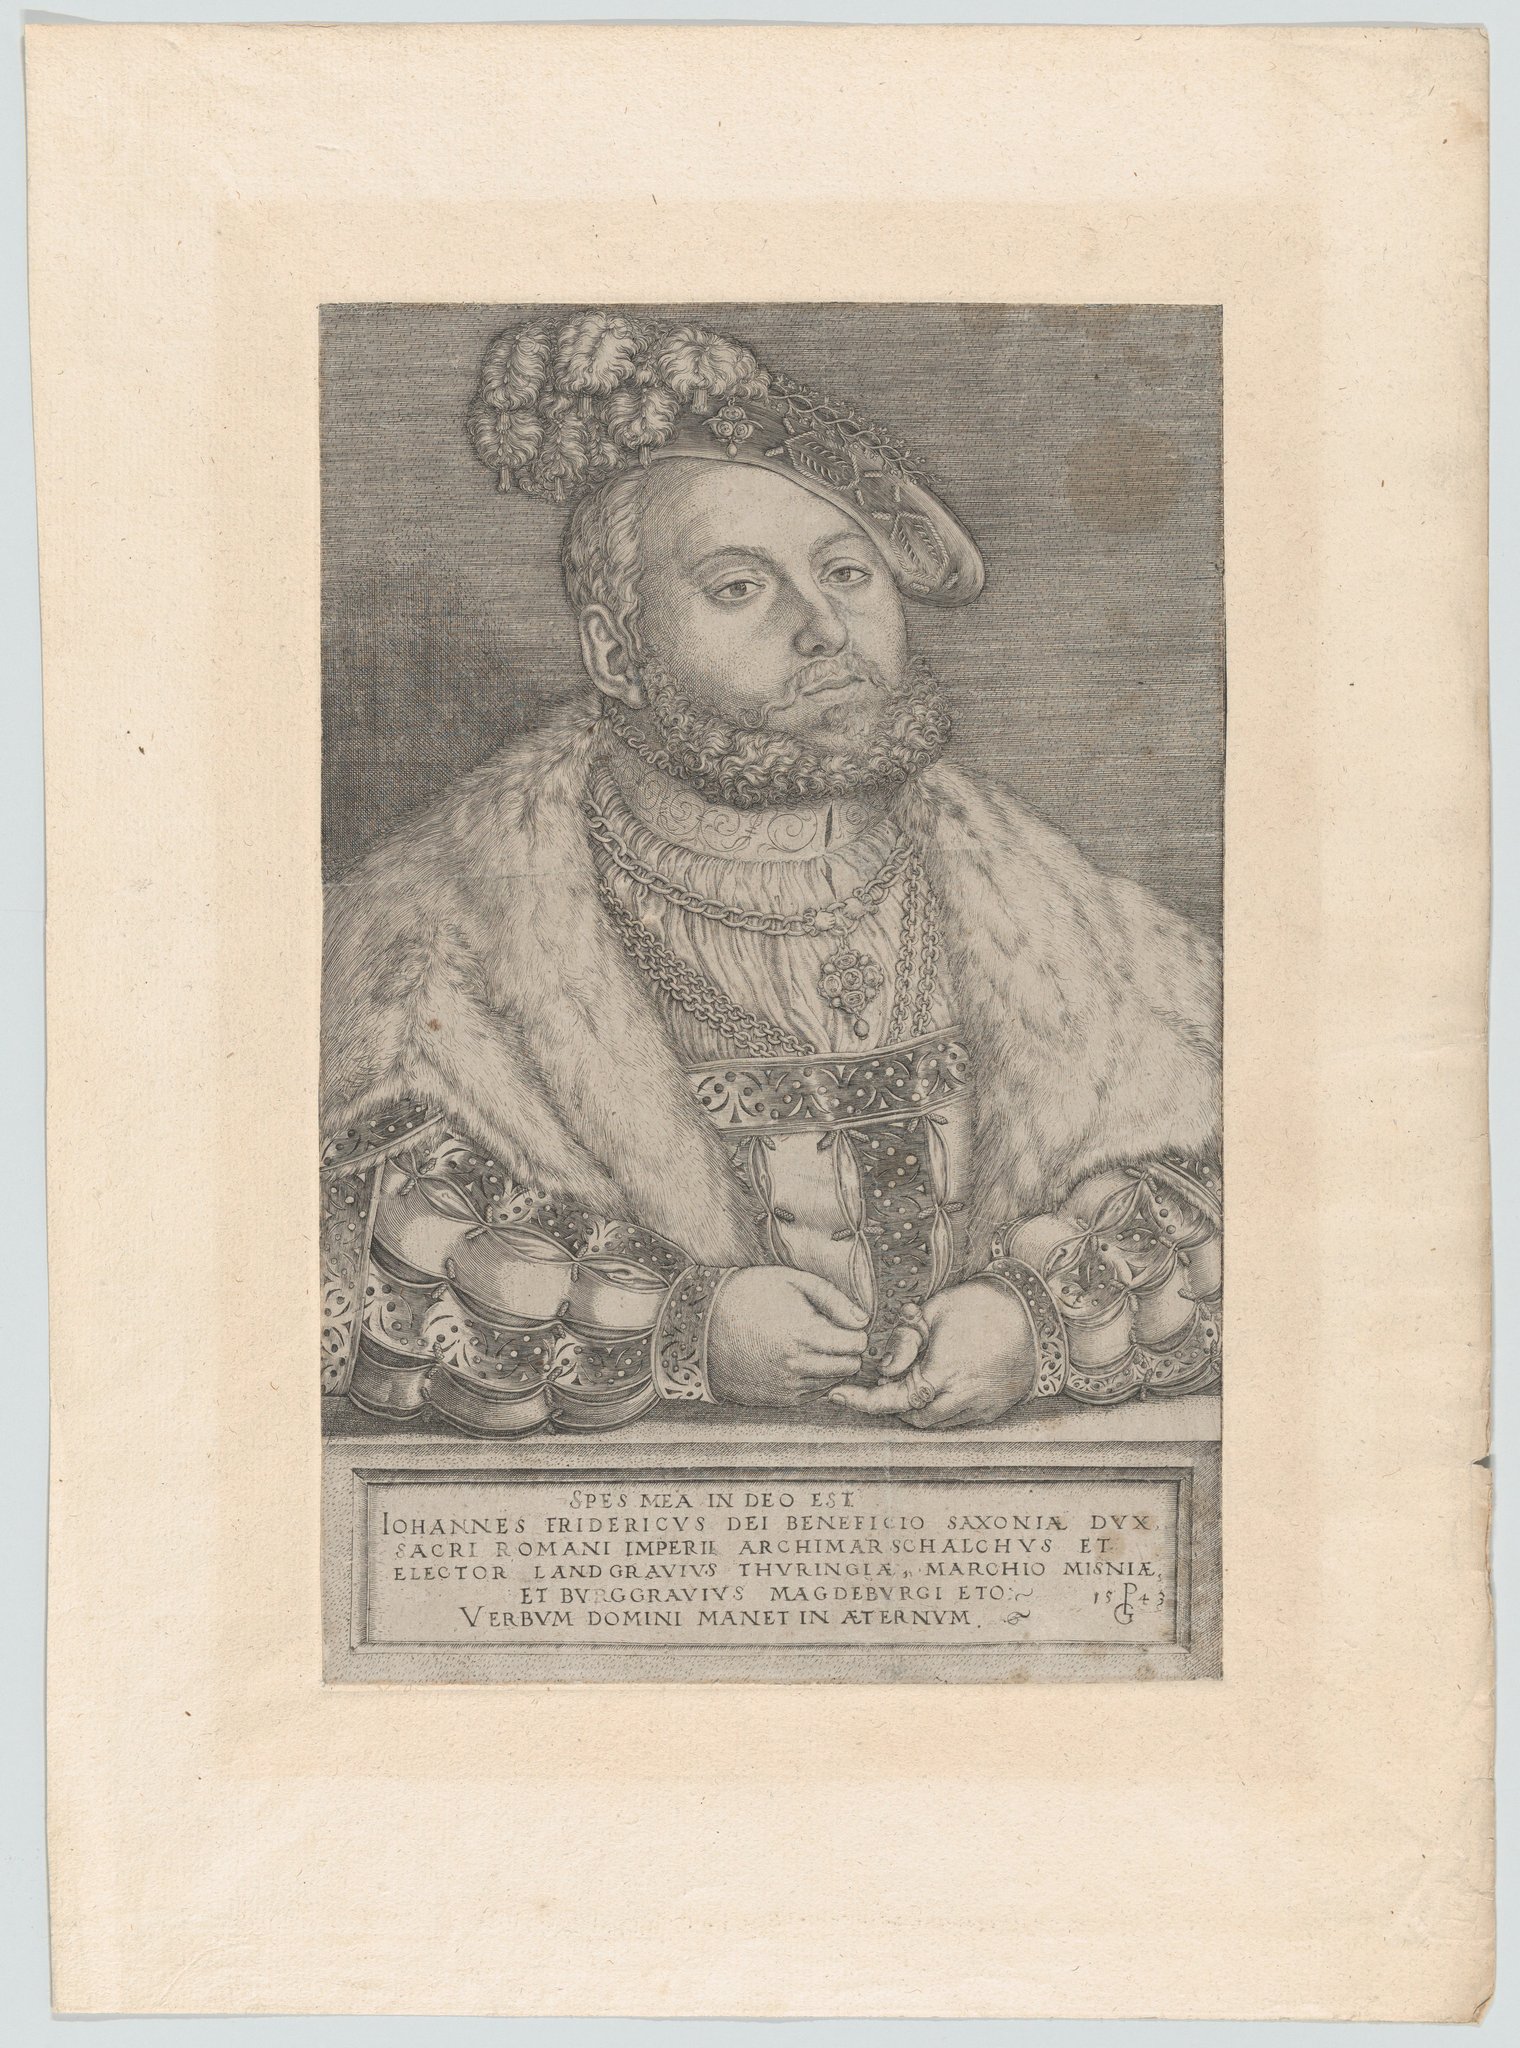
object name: print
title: Portrait of Johann Friedrich the Magnanimous, Elector of Saxony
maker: georg pencz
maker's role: artist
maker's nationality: german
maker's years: 1500-1550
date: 1543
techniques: engraving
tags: men,portraits